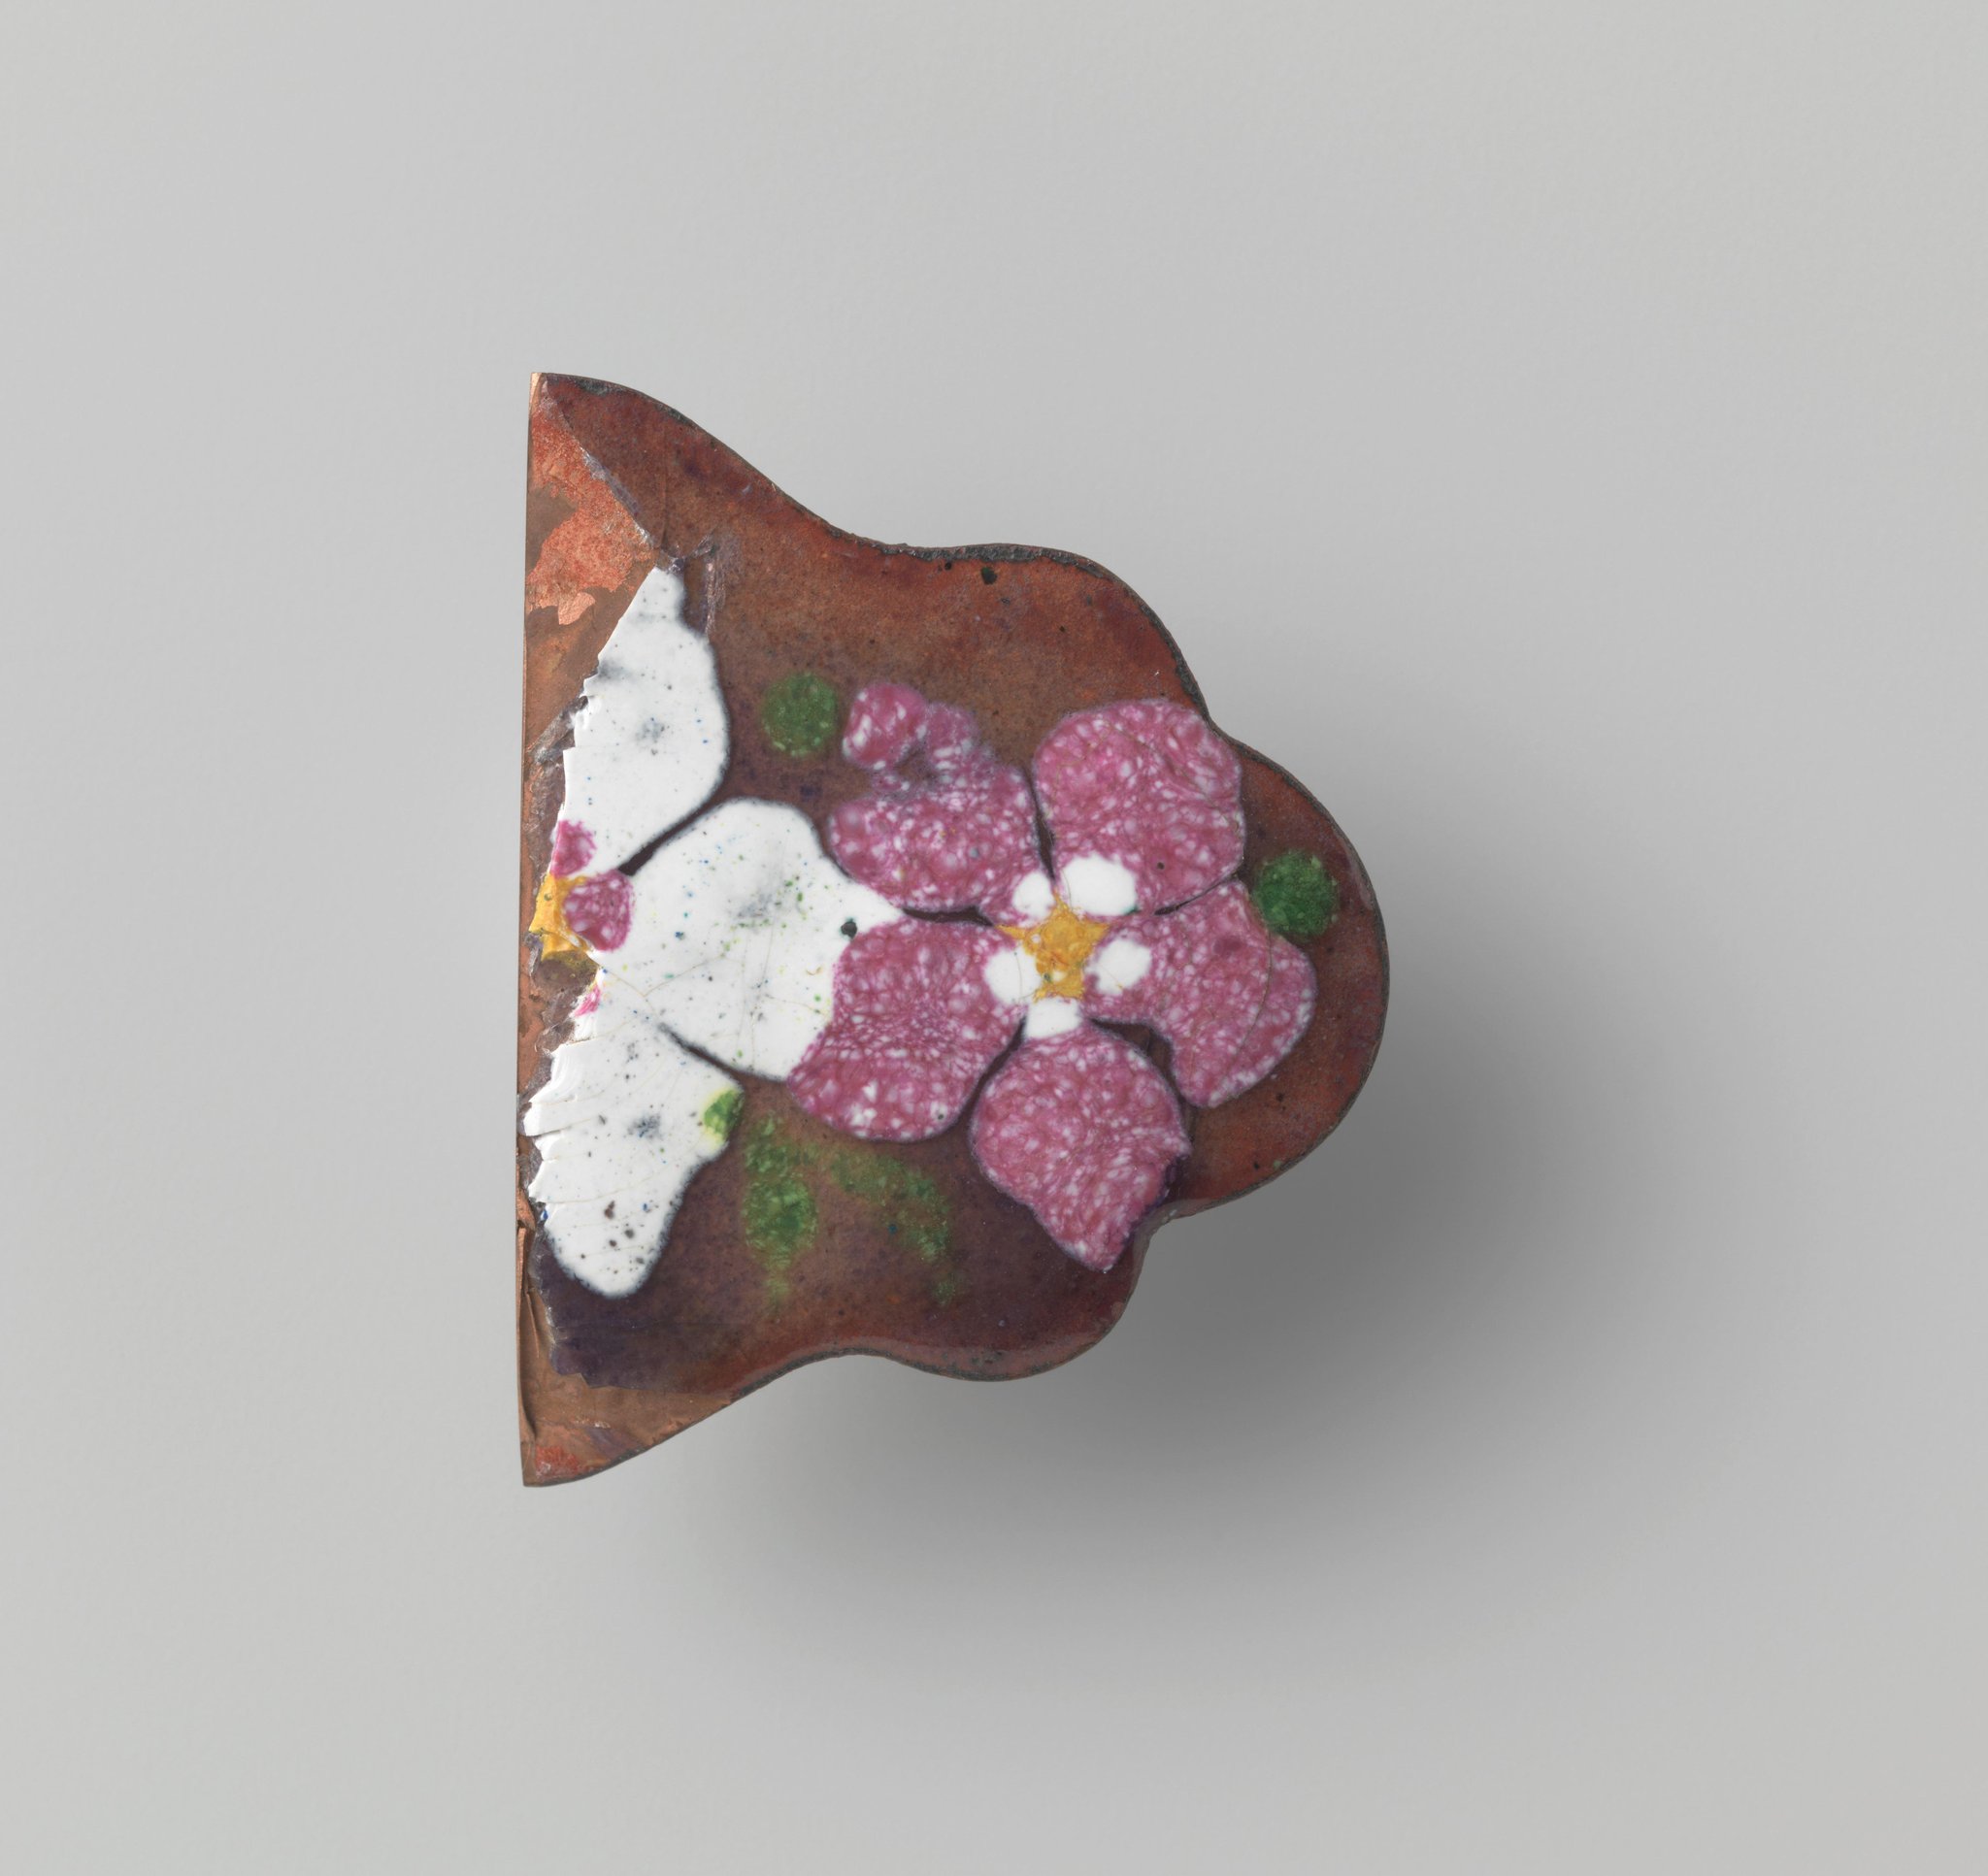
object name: fragment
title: Helft van een doorgezaagde broche van email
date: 1998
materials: metal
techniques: sawing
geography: bussum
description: Helft van een doorgezaagde broche van email met bloemdecoratie op rood fond; de andere helft van de broche is verwerkt in een hanger samengesteld uit doorgezaagde sieraden aan koordketting van zilver. De doorgezaagde sieraden zijn afkomstig van de moeder van Marjan Unger.